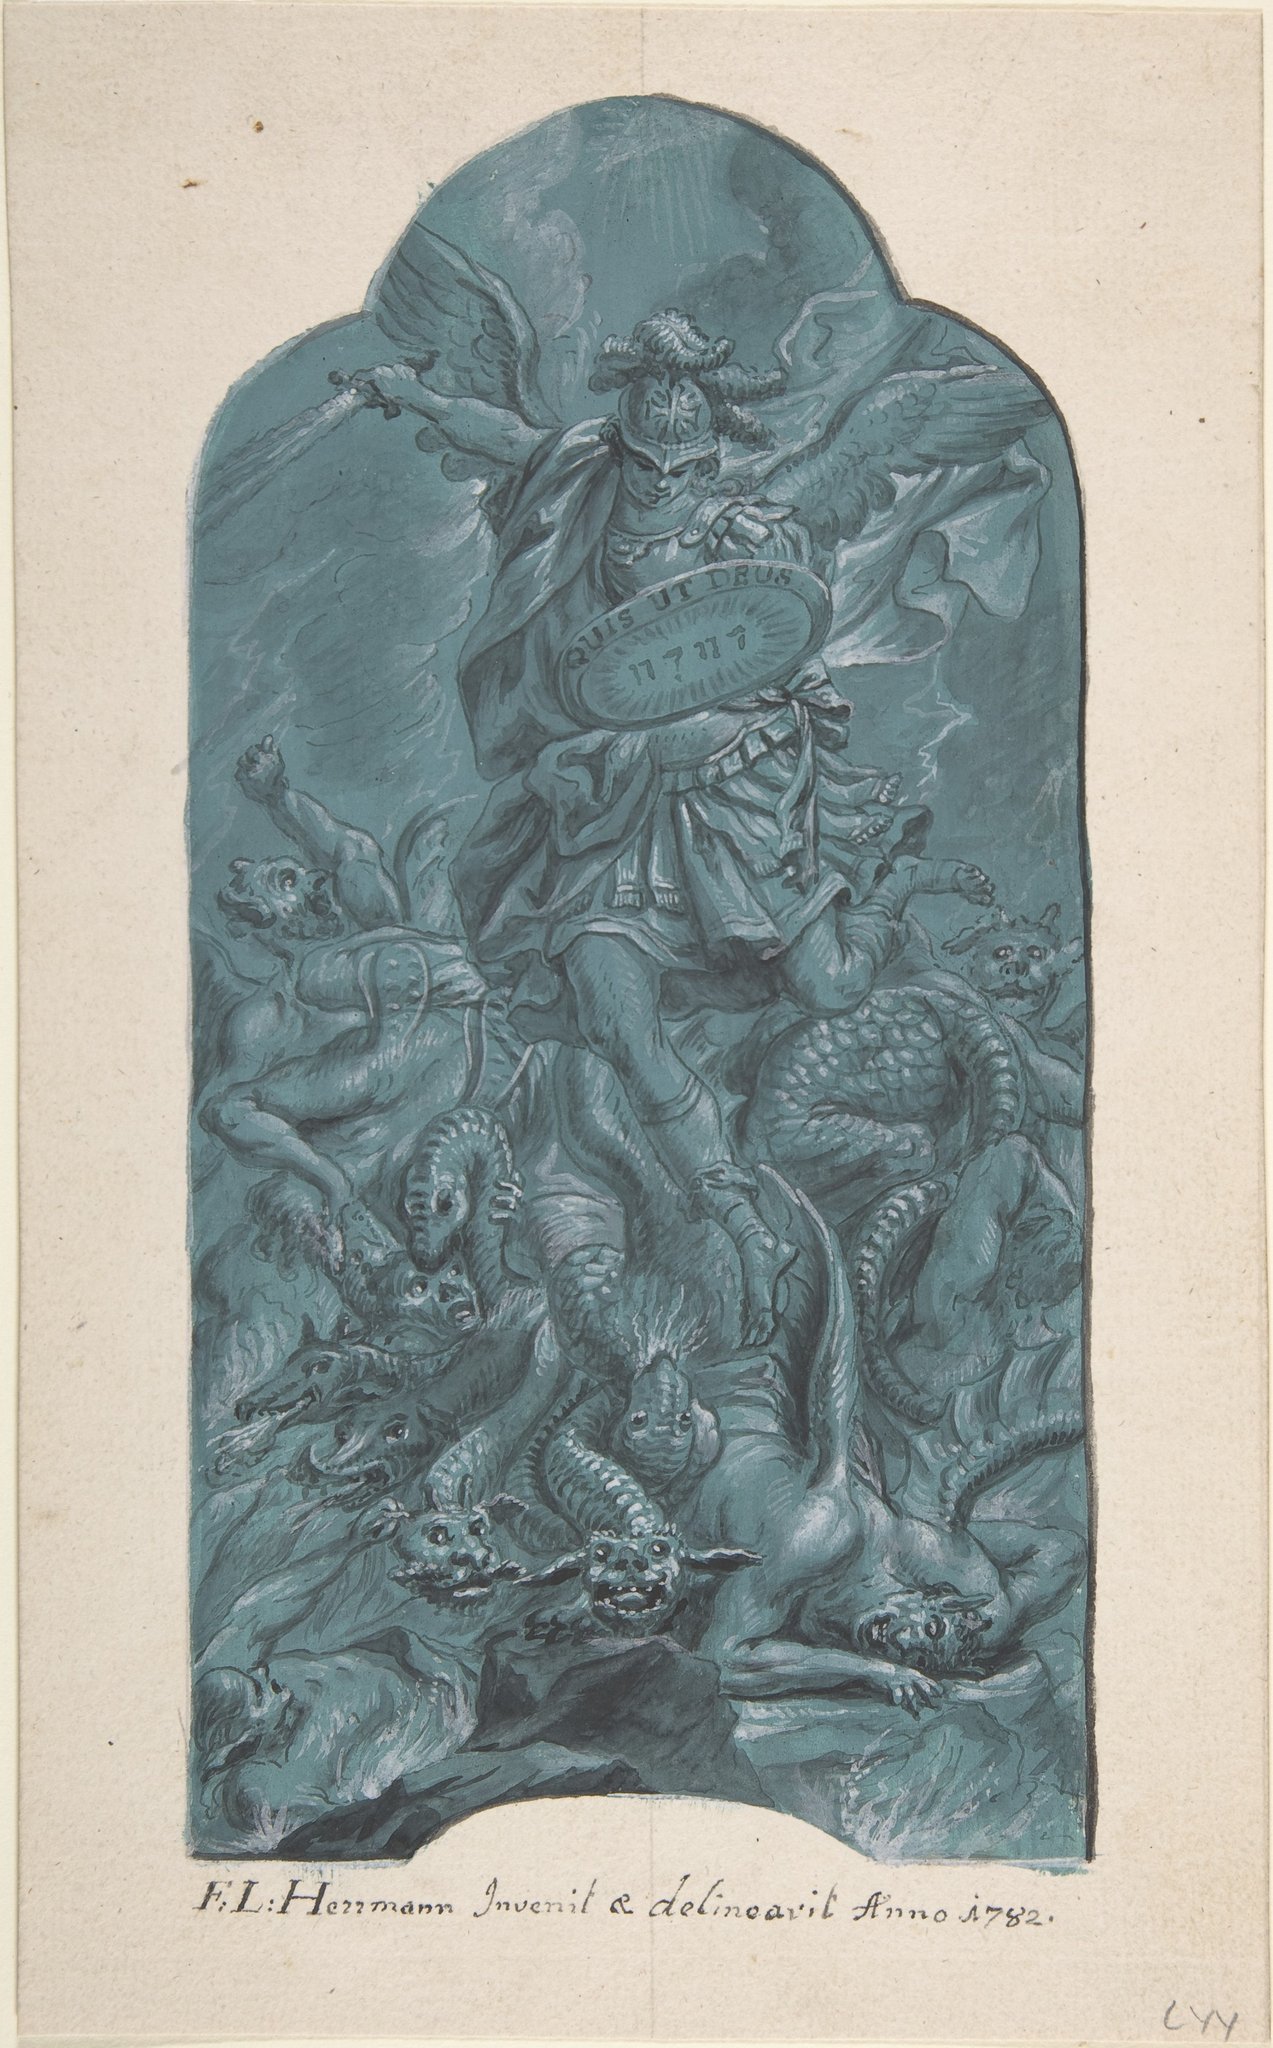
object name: drawing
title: The Archangel Michael Banishing Vice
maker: franz ludwig hermann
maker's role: artist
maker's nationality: german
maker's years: 1710-1791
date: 1782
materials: gouache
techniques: brush, heightening, wash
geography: netherlands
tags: monsters,angels